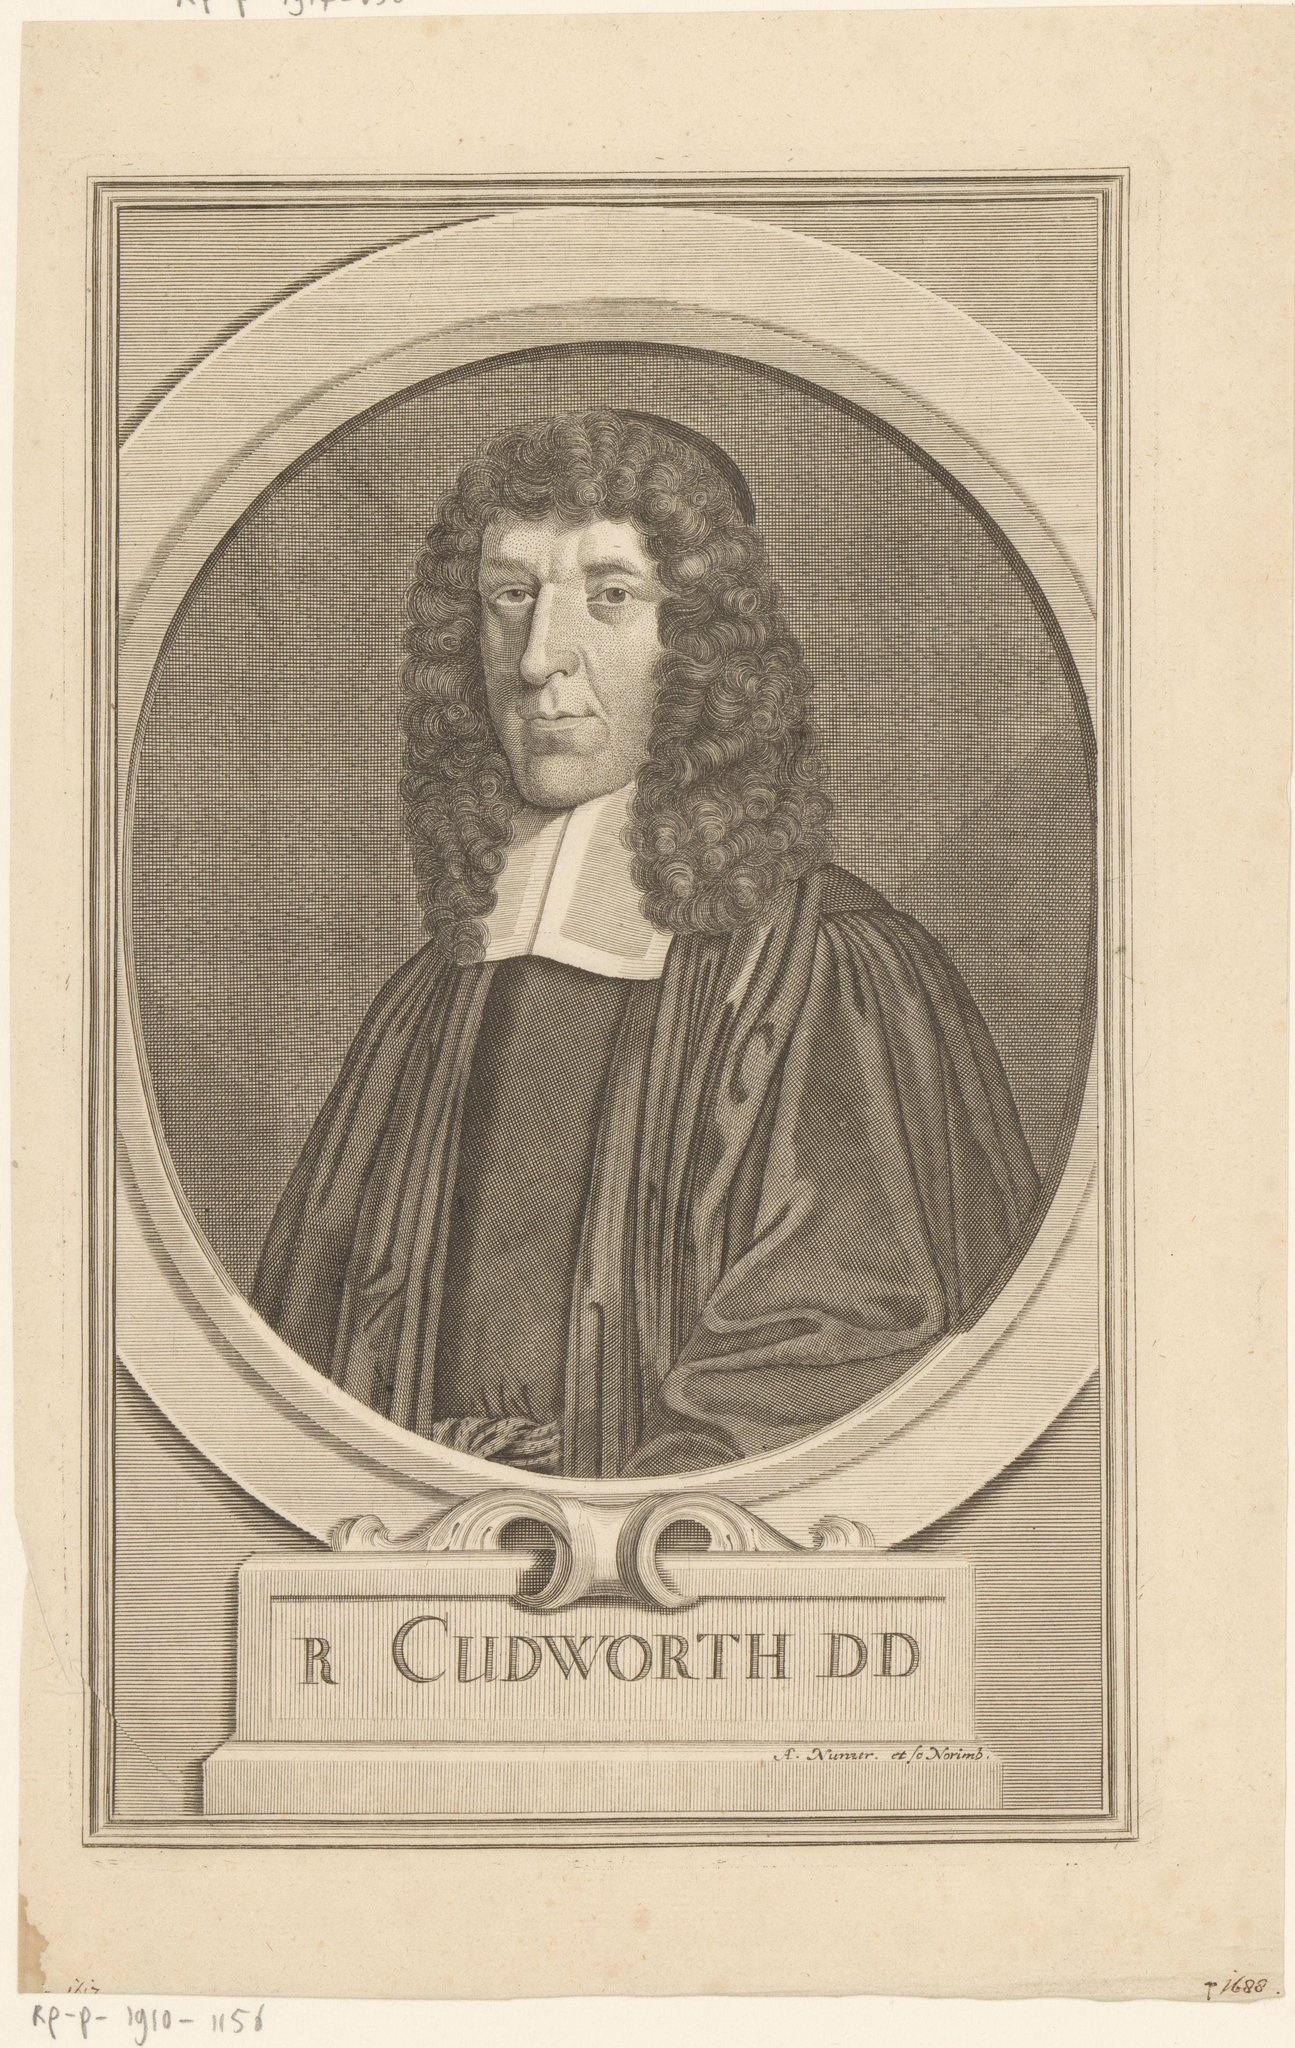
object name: print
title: Portret van Ralph Cudworth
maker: andreas nunzer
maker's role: print maker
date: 1700-1749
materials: paper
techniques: engraving, etching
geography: nuremberg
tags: historical persons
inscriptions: collector's mark: Lugt 2228